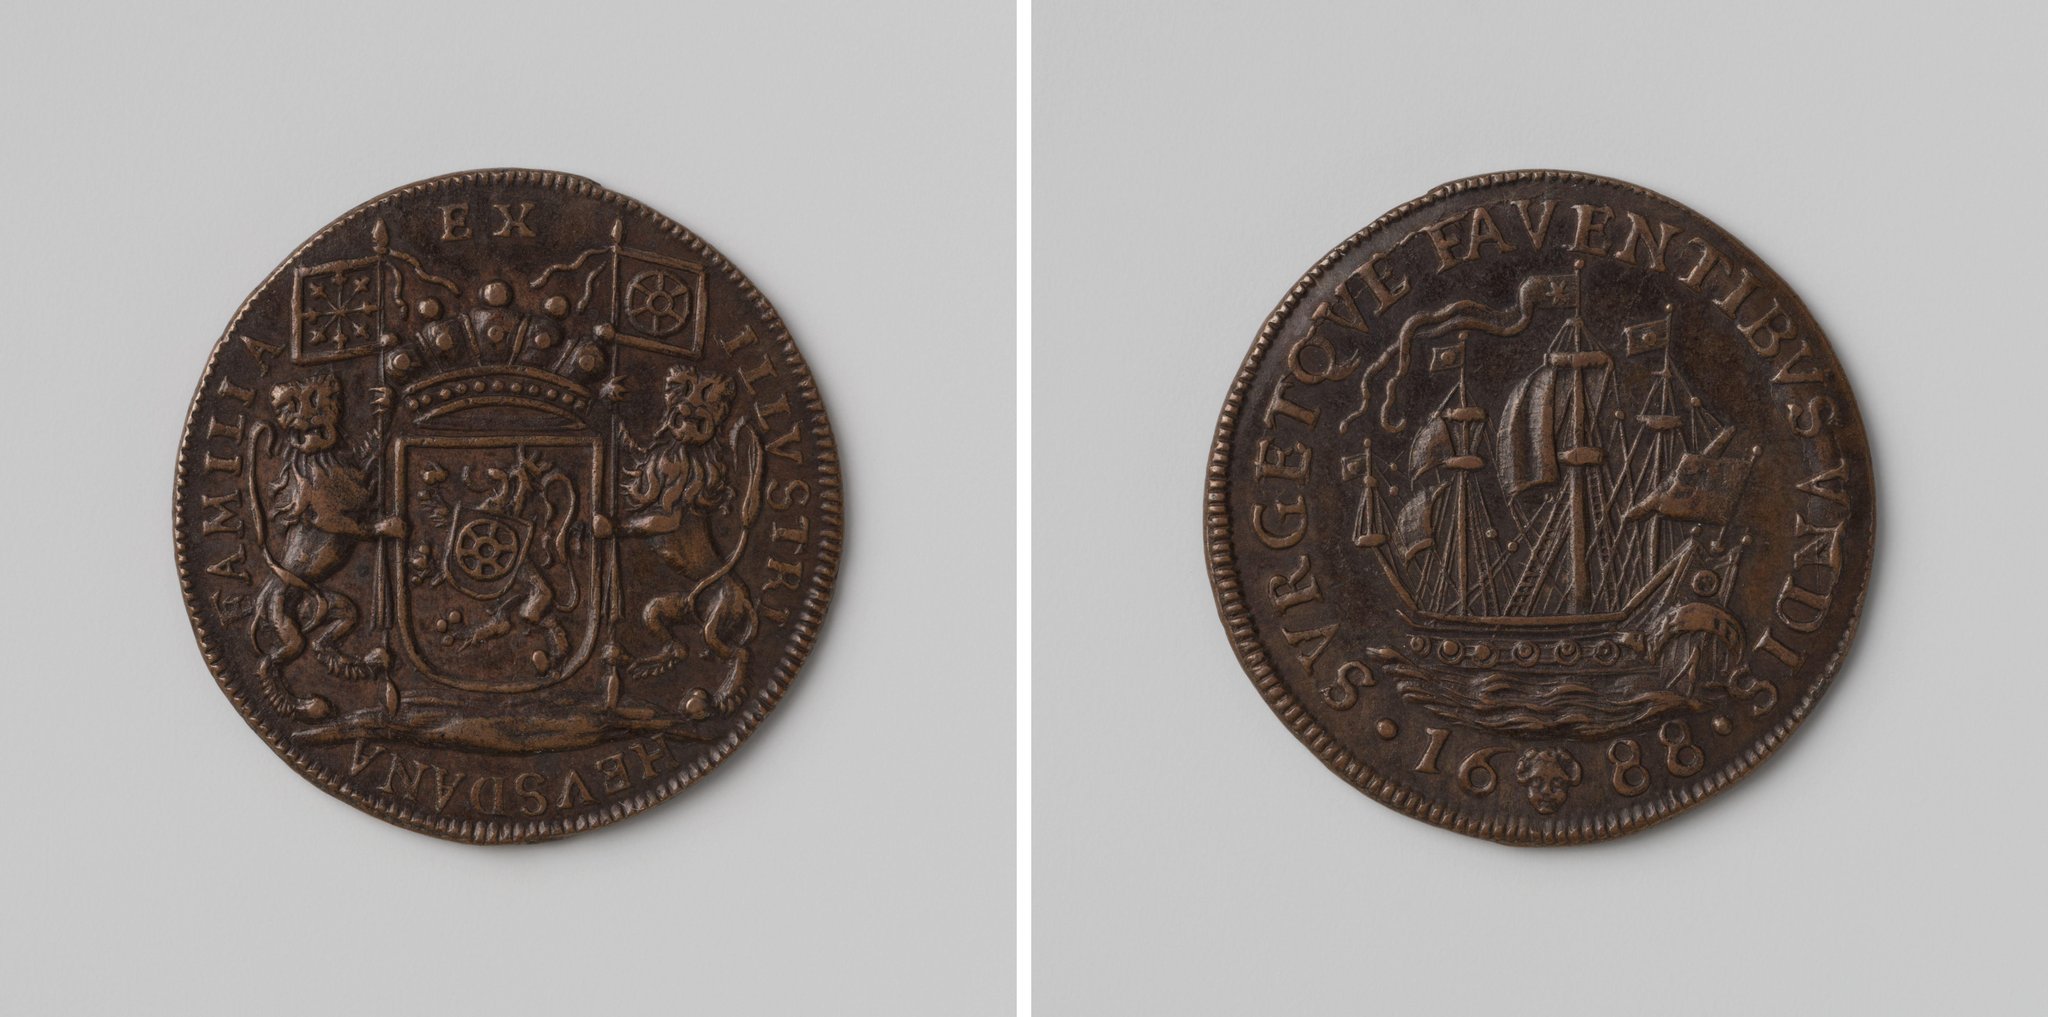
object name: jeton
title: Theodore d'Elshout, bijgenaamd Van Heusden, heer van Middelswale, vijfenvijftigste intendant van de vaart van Brussel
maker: Anonymous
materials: copper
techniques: striking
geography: brussels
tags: theodore de elshout, willebroekse vaart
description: Koperen penning. Voorzijde: wapenschild aan lint, geflankeerd door twee leeuwen met banier binnen omschrift; afsnede: jaartal. Keerzijde: schip op water, voortgeblazen door wind binnen omschrift